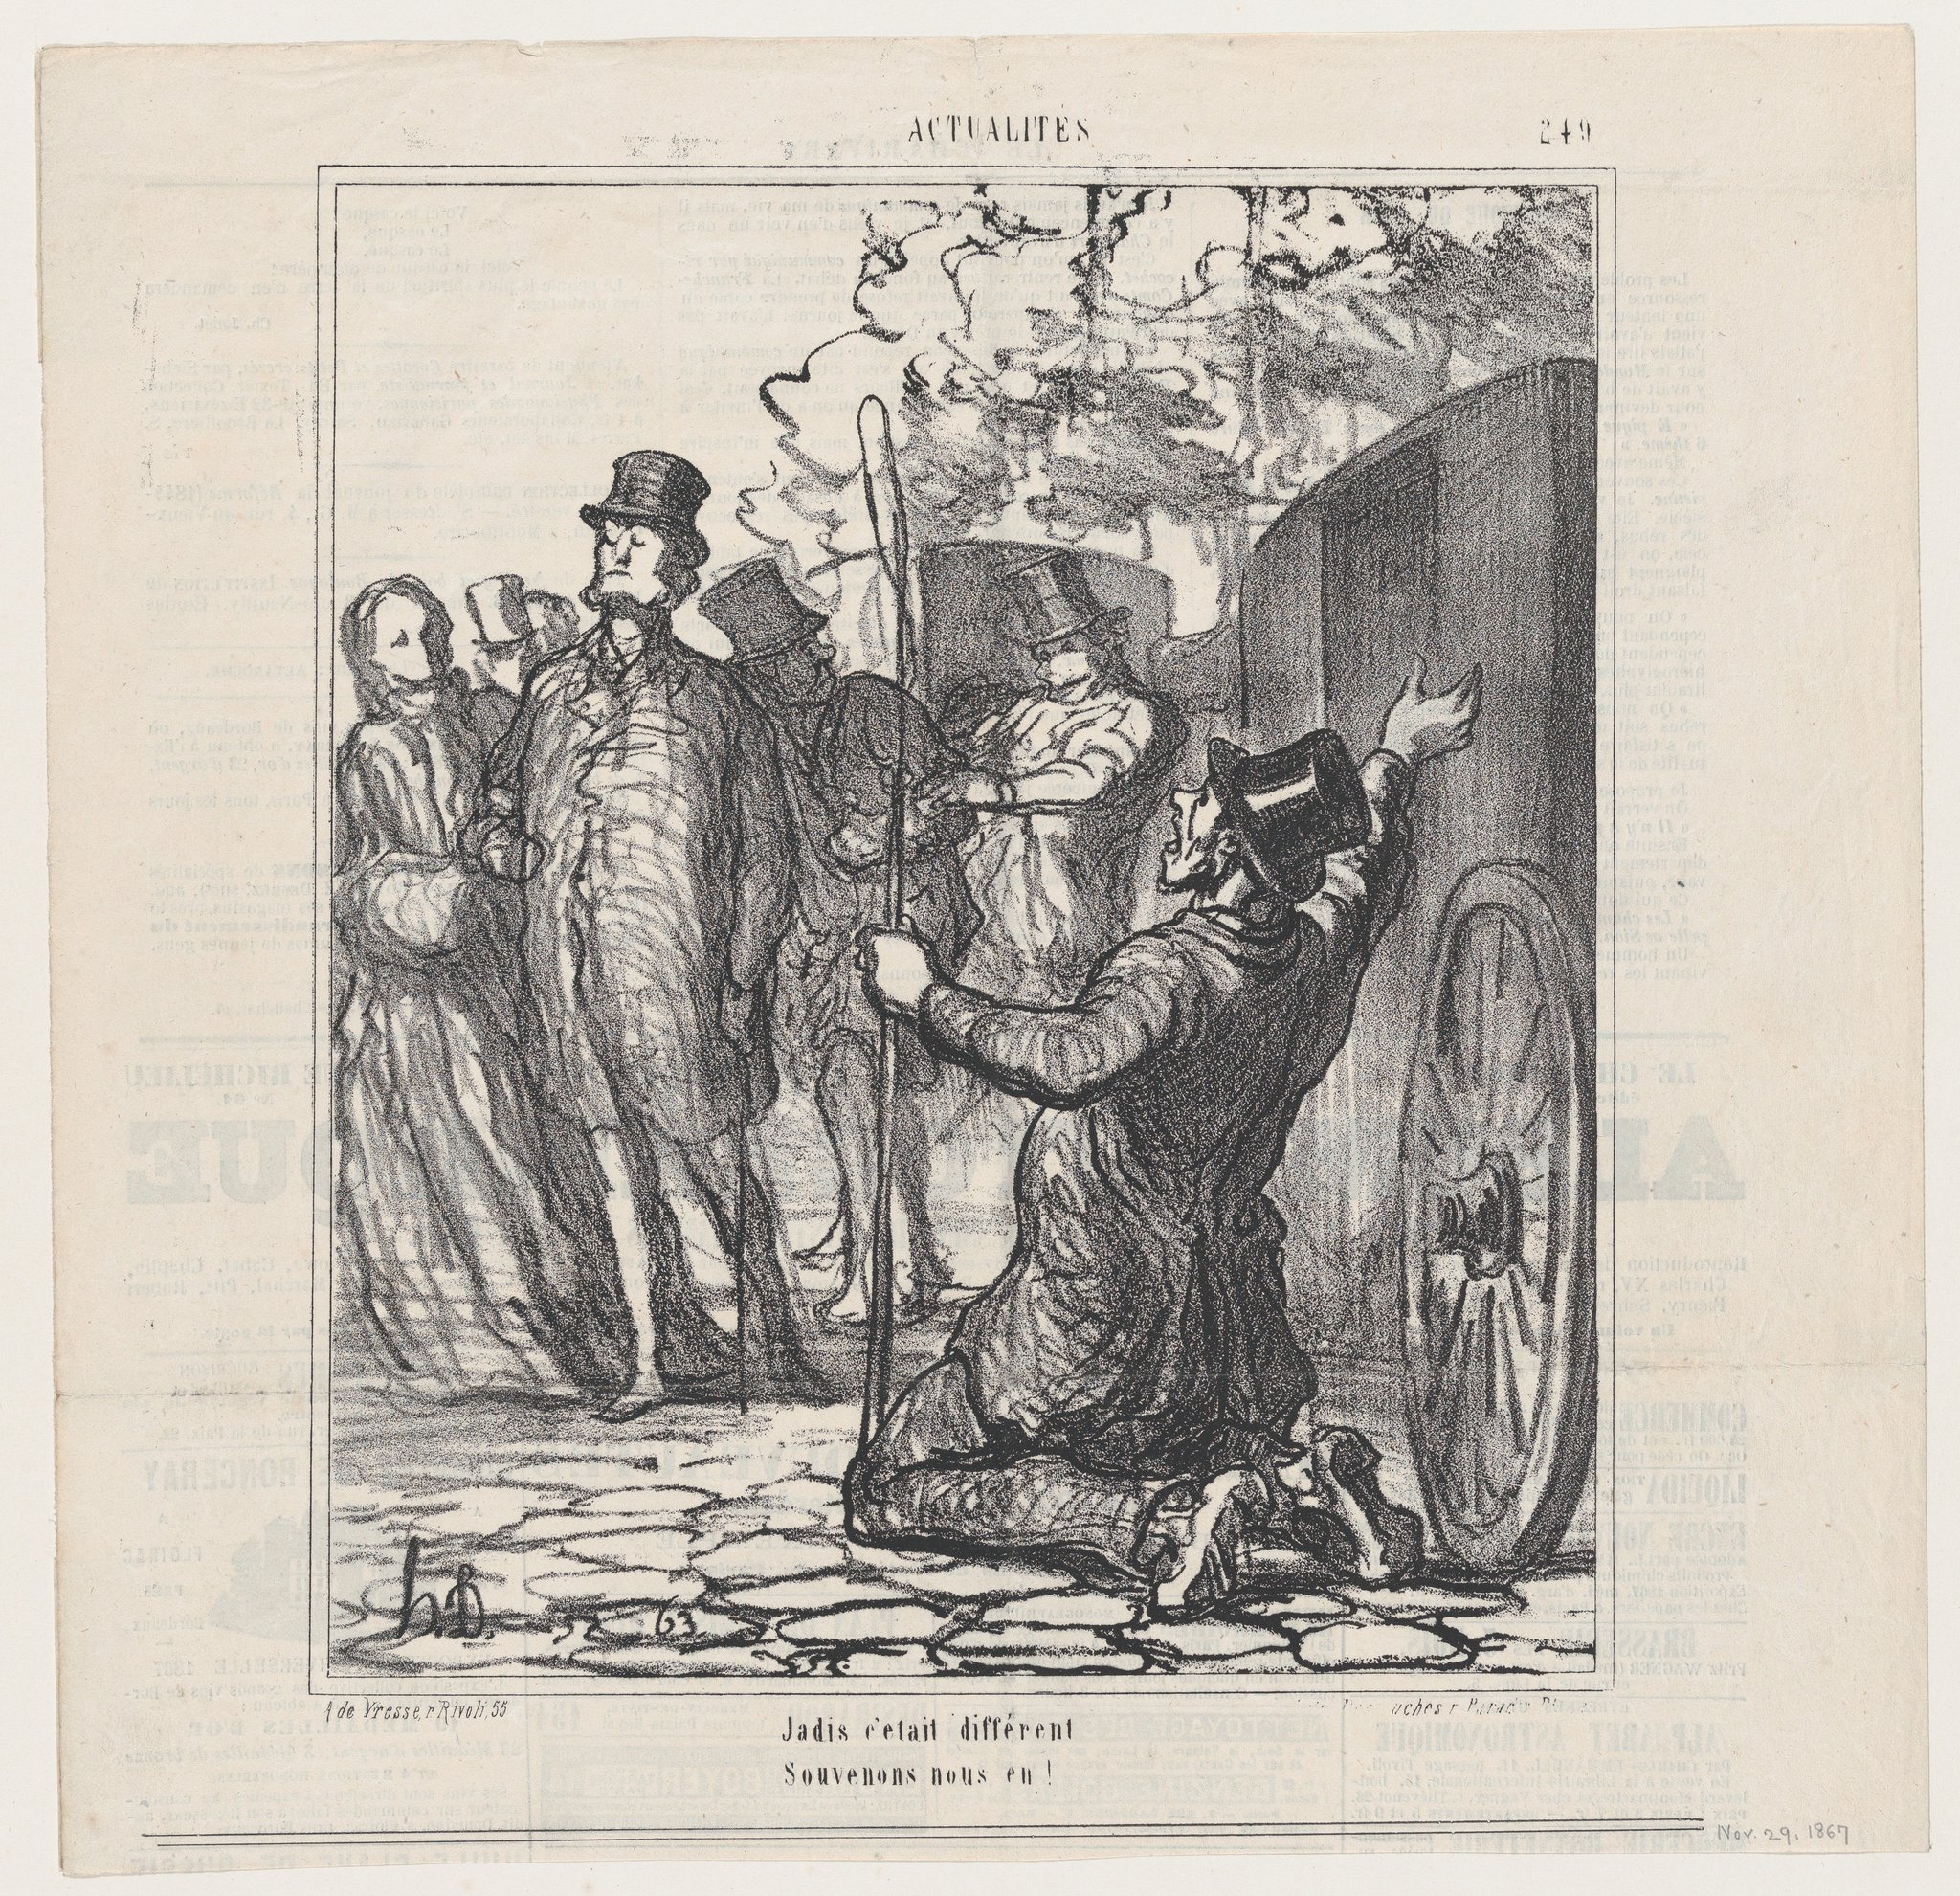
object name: print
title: In the past it was different. Let us try to remember, from 'News of the day,' published in Le Charivari, November 29, 1867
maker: honoré daumier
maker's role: artist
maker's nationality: french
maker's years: 1808-1879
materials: paper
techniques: lithograph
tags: men,women,carriages